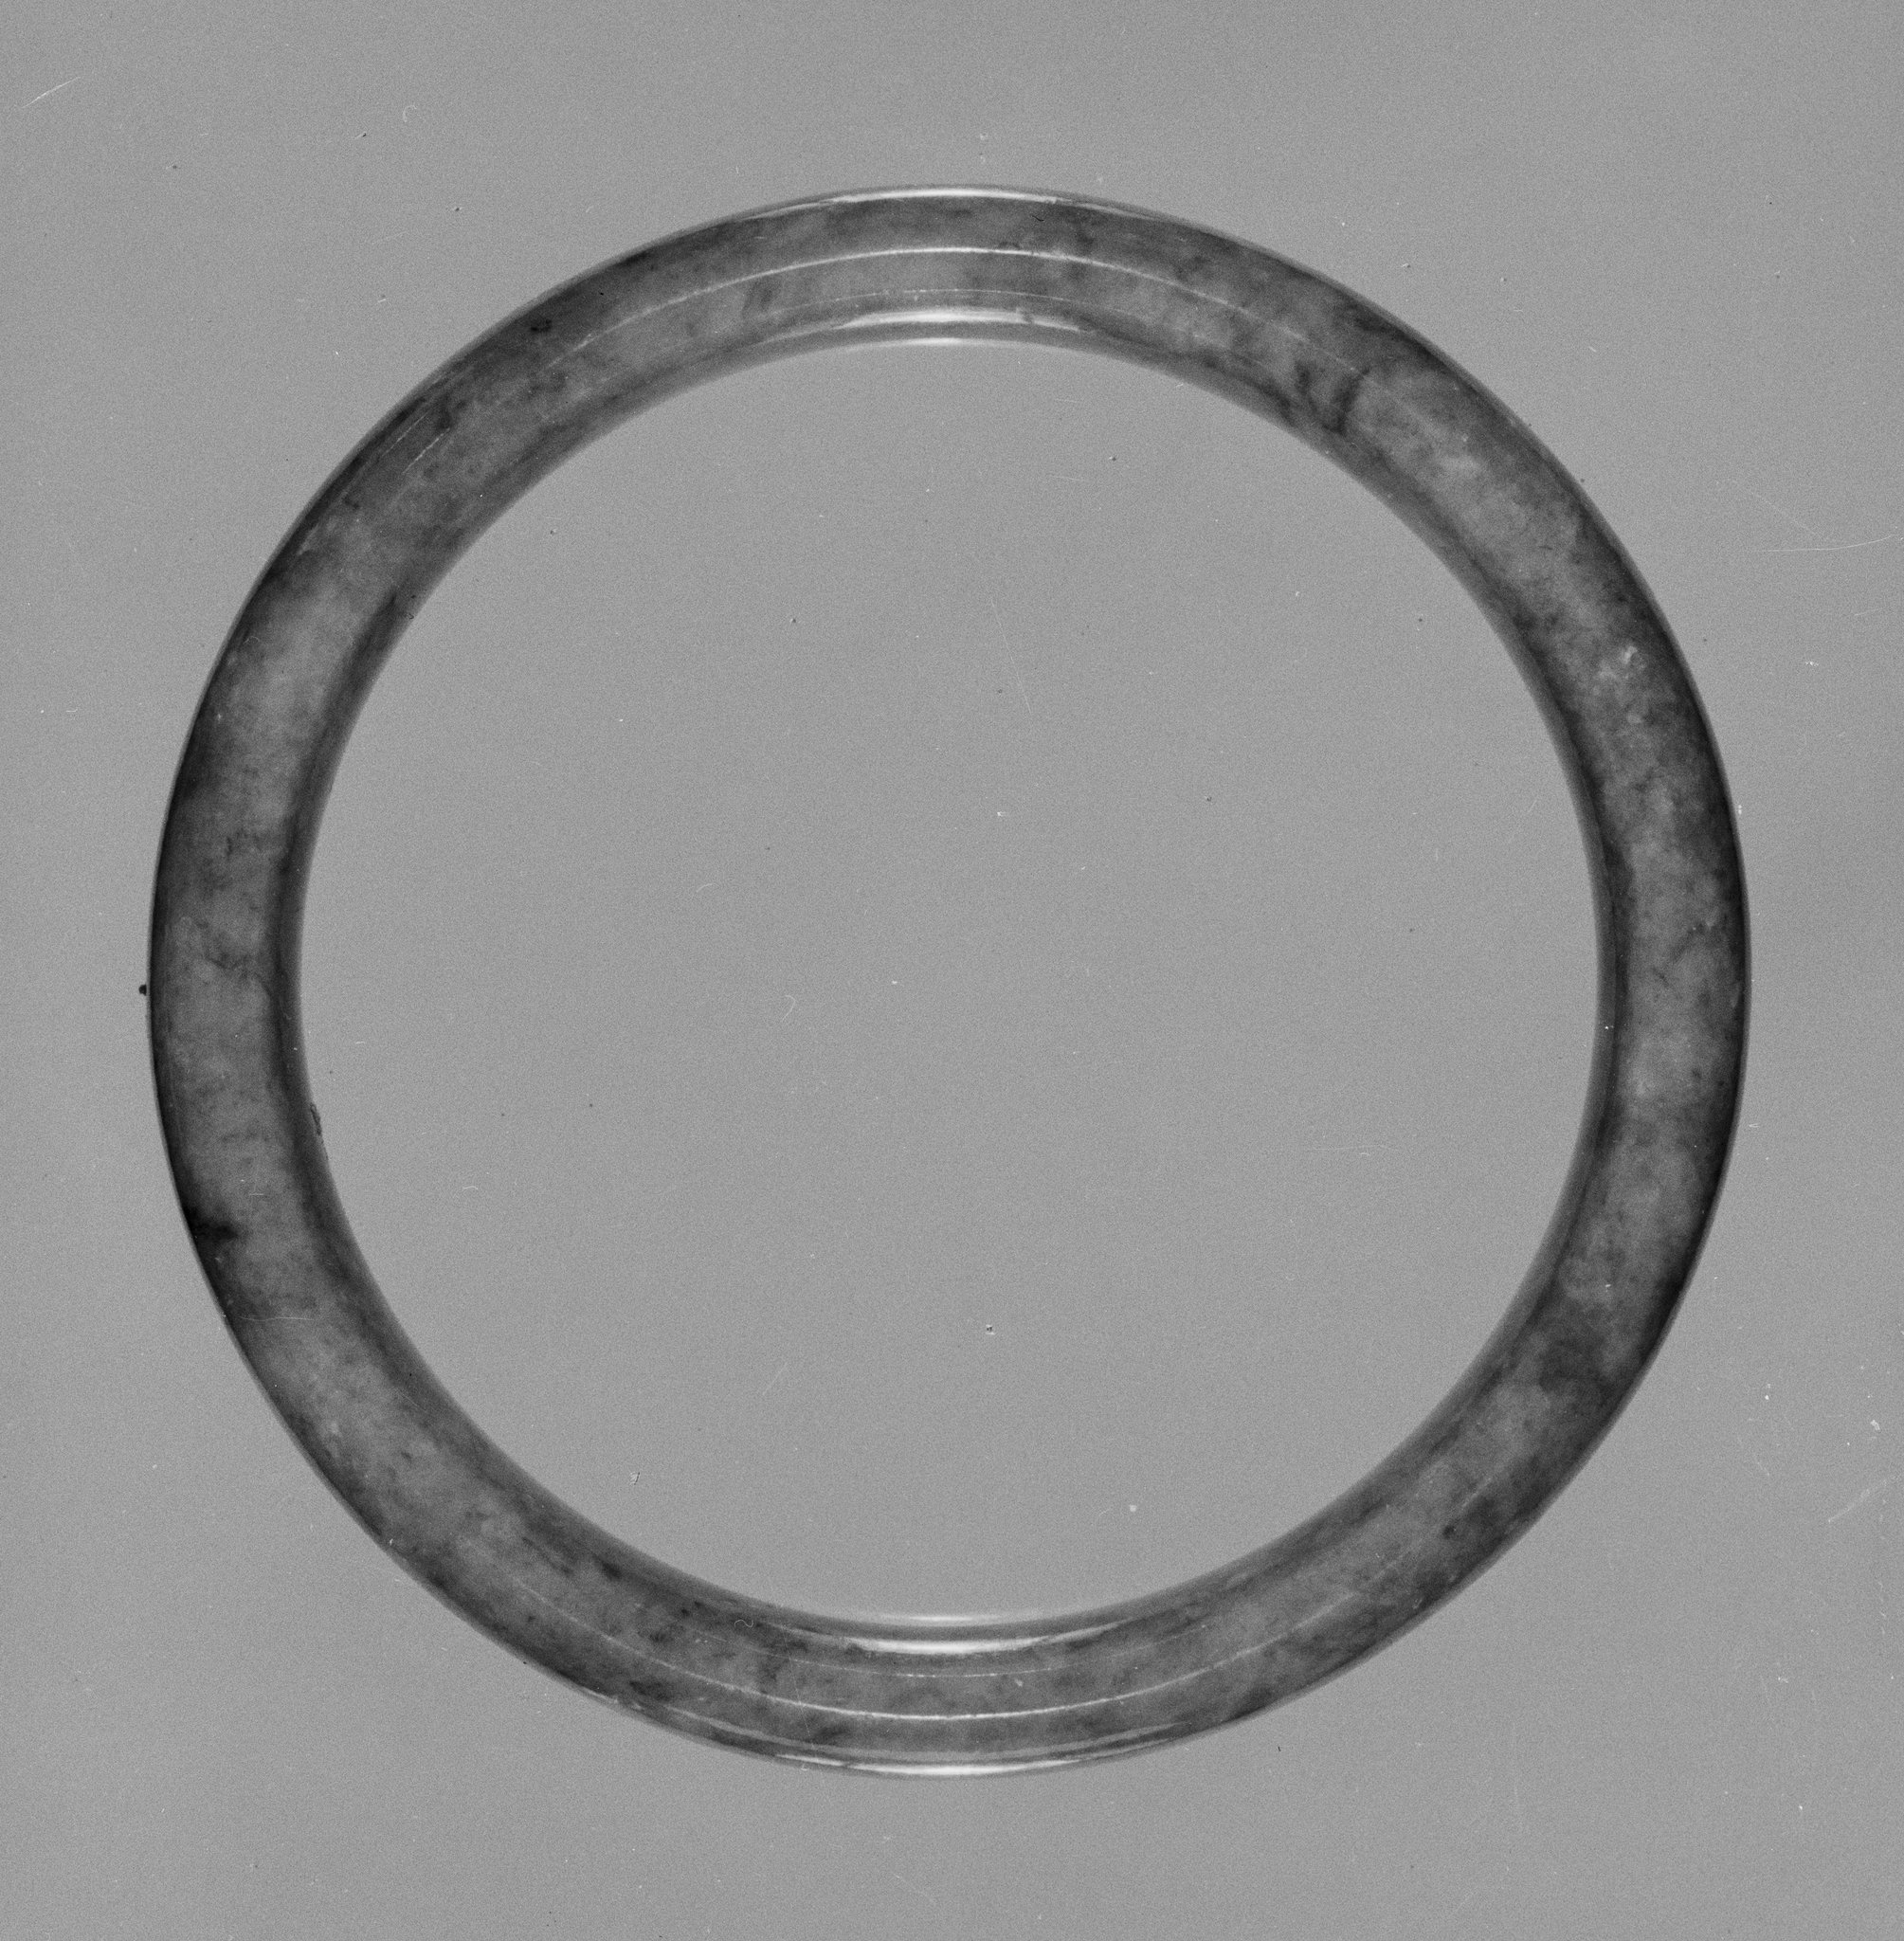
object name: bracelet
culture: chinese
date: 1901-2000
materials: jade